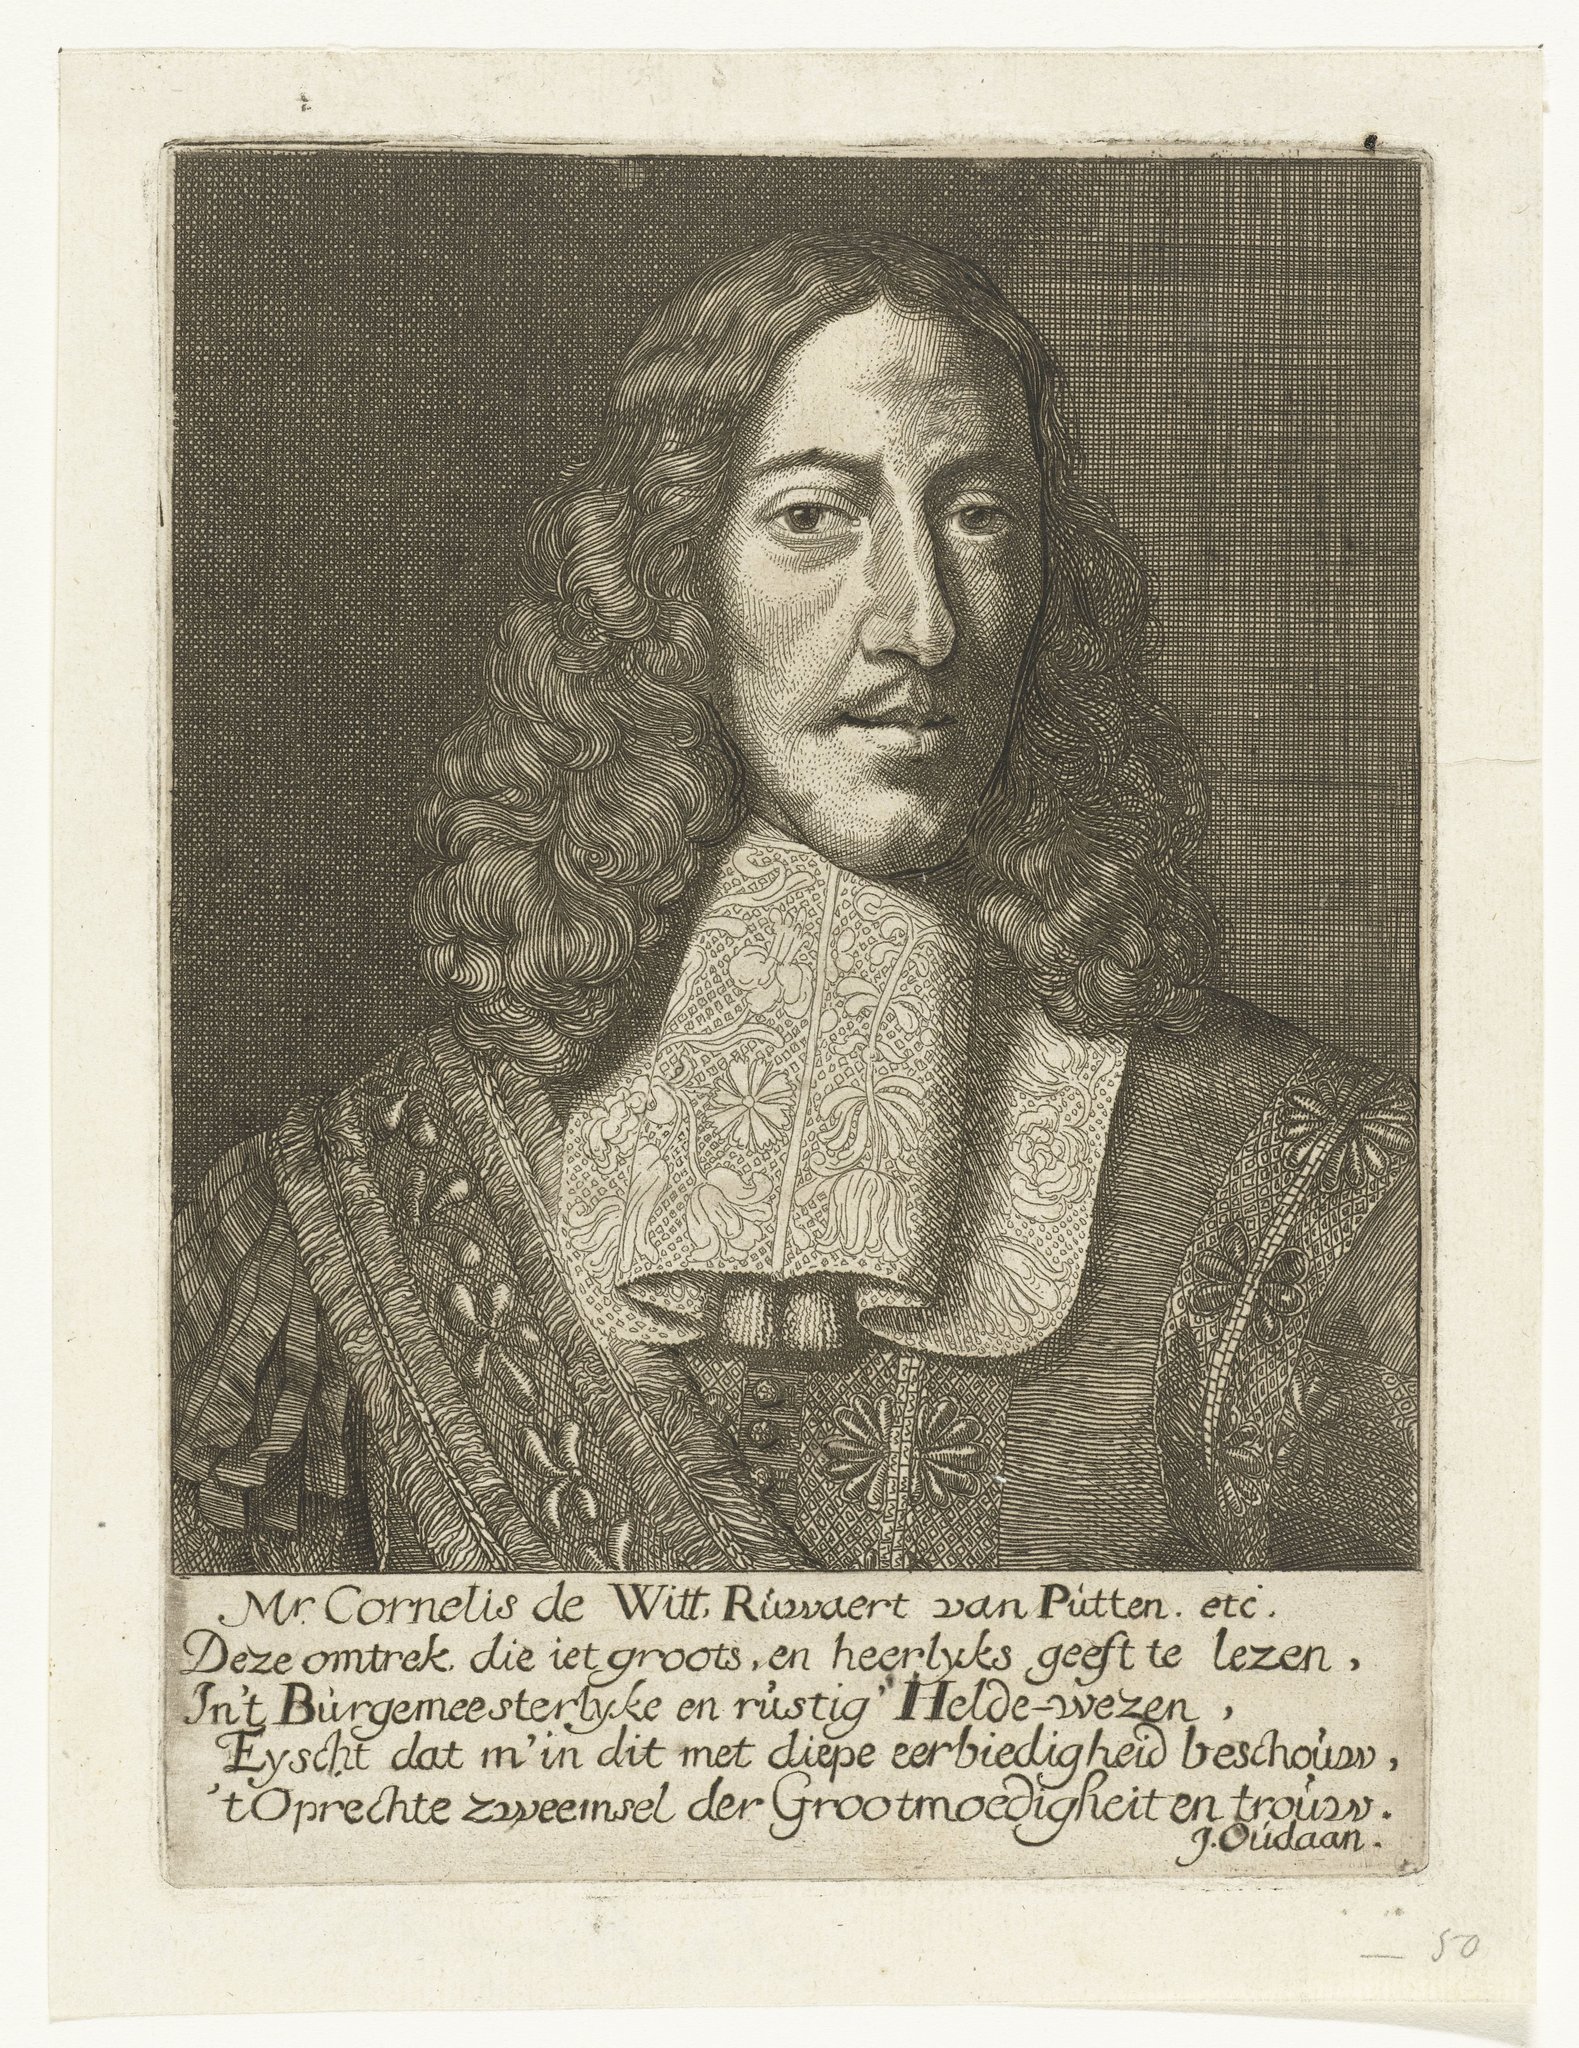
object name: print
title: Portret van Cornelis de Witt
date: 1648-1677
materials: paper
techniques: engraving, etching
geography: netherlands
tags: dordrecht, the hague, cornelis de witt, historical persons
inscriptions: collector's mark: Lugt 2228a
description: Buste van Cornelis de Witt, lid van de admiraliteit van Rotterdam, ruwaard van Putten en baljuw van de Beijerlanden. Onder het portret vijfregelige tekst in het Nederlands van J. Oudaan.